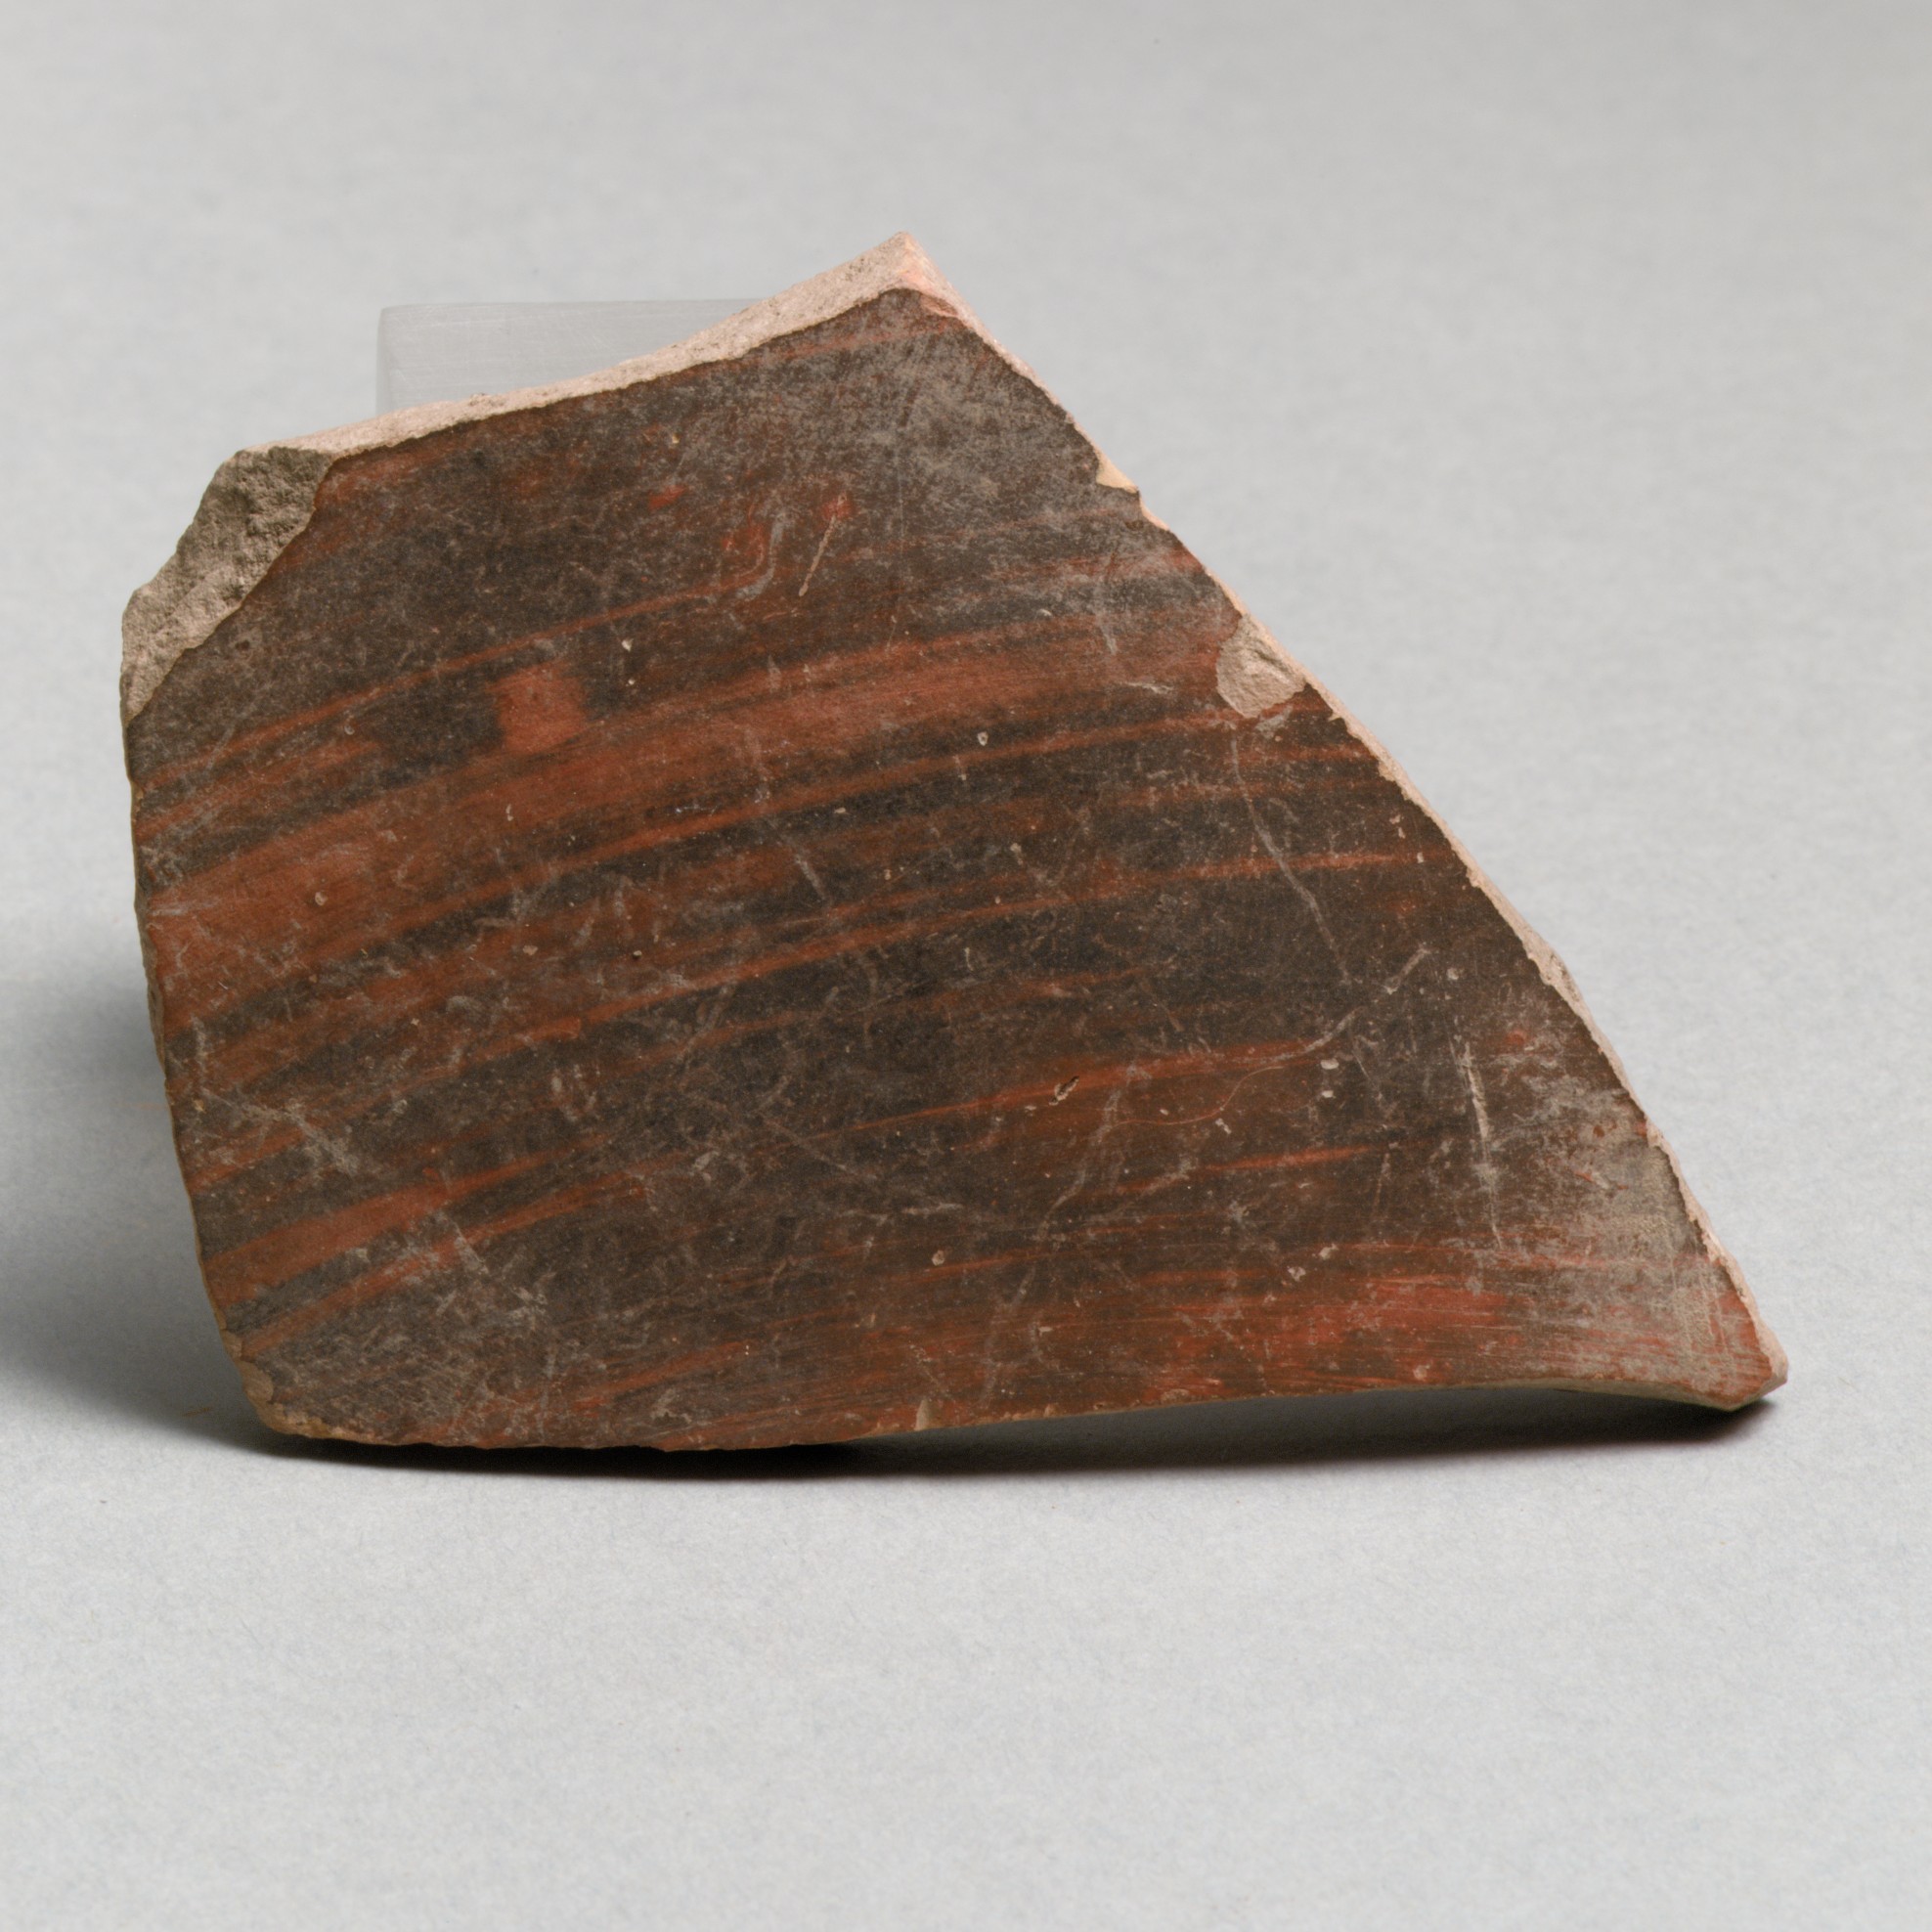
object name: vase fragment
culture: greek or lydian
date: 900-30 BCE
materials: terracotta